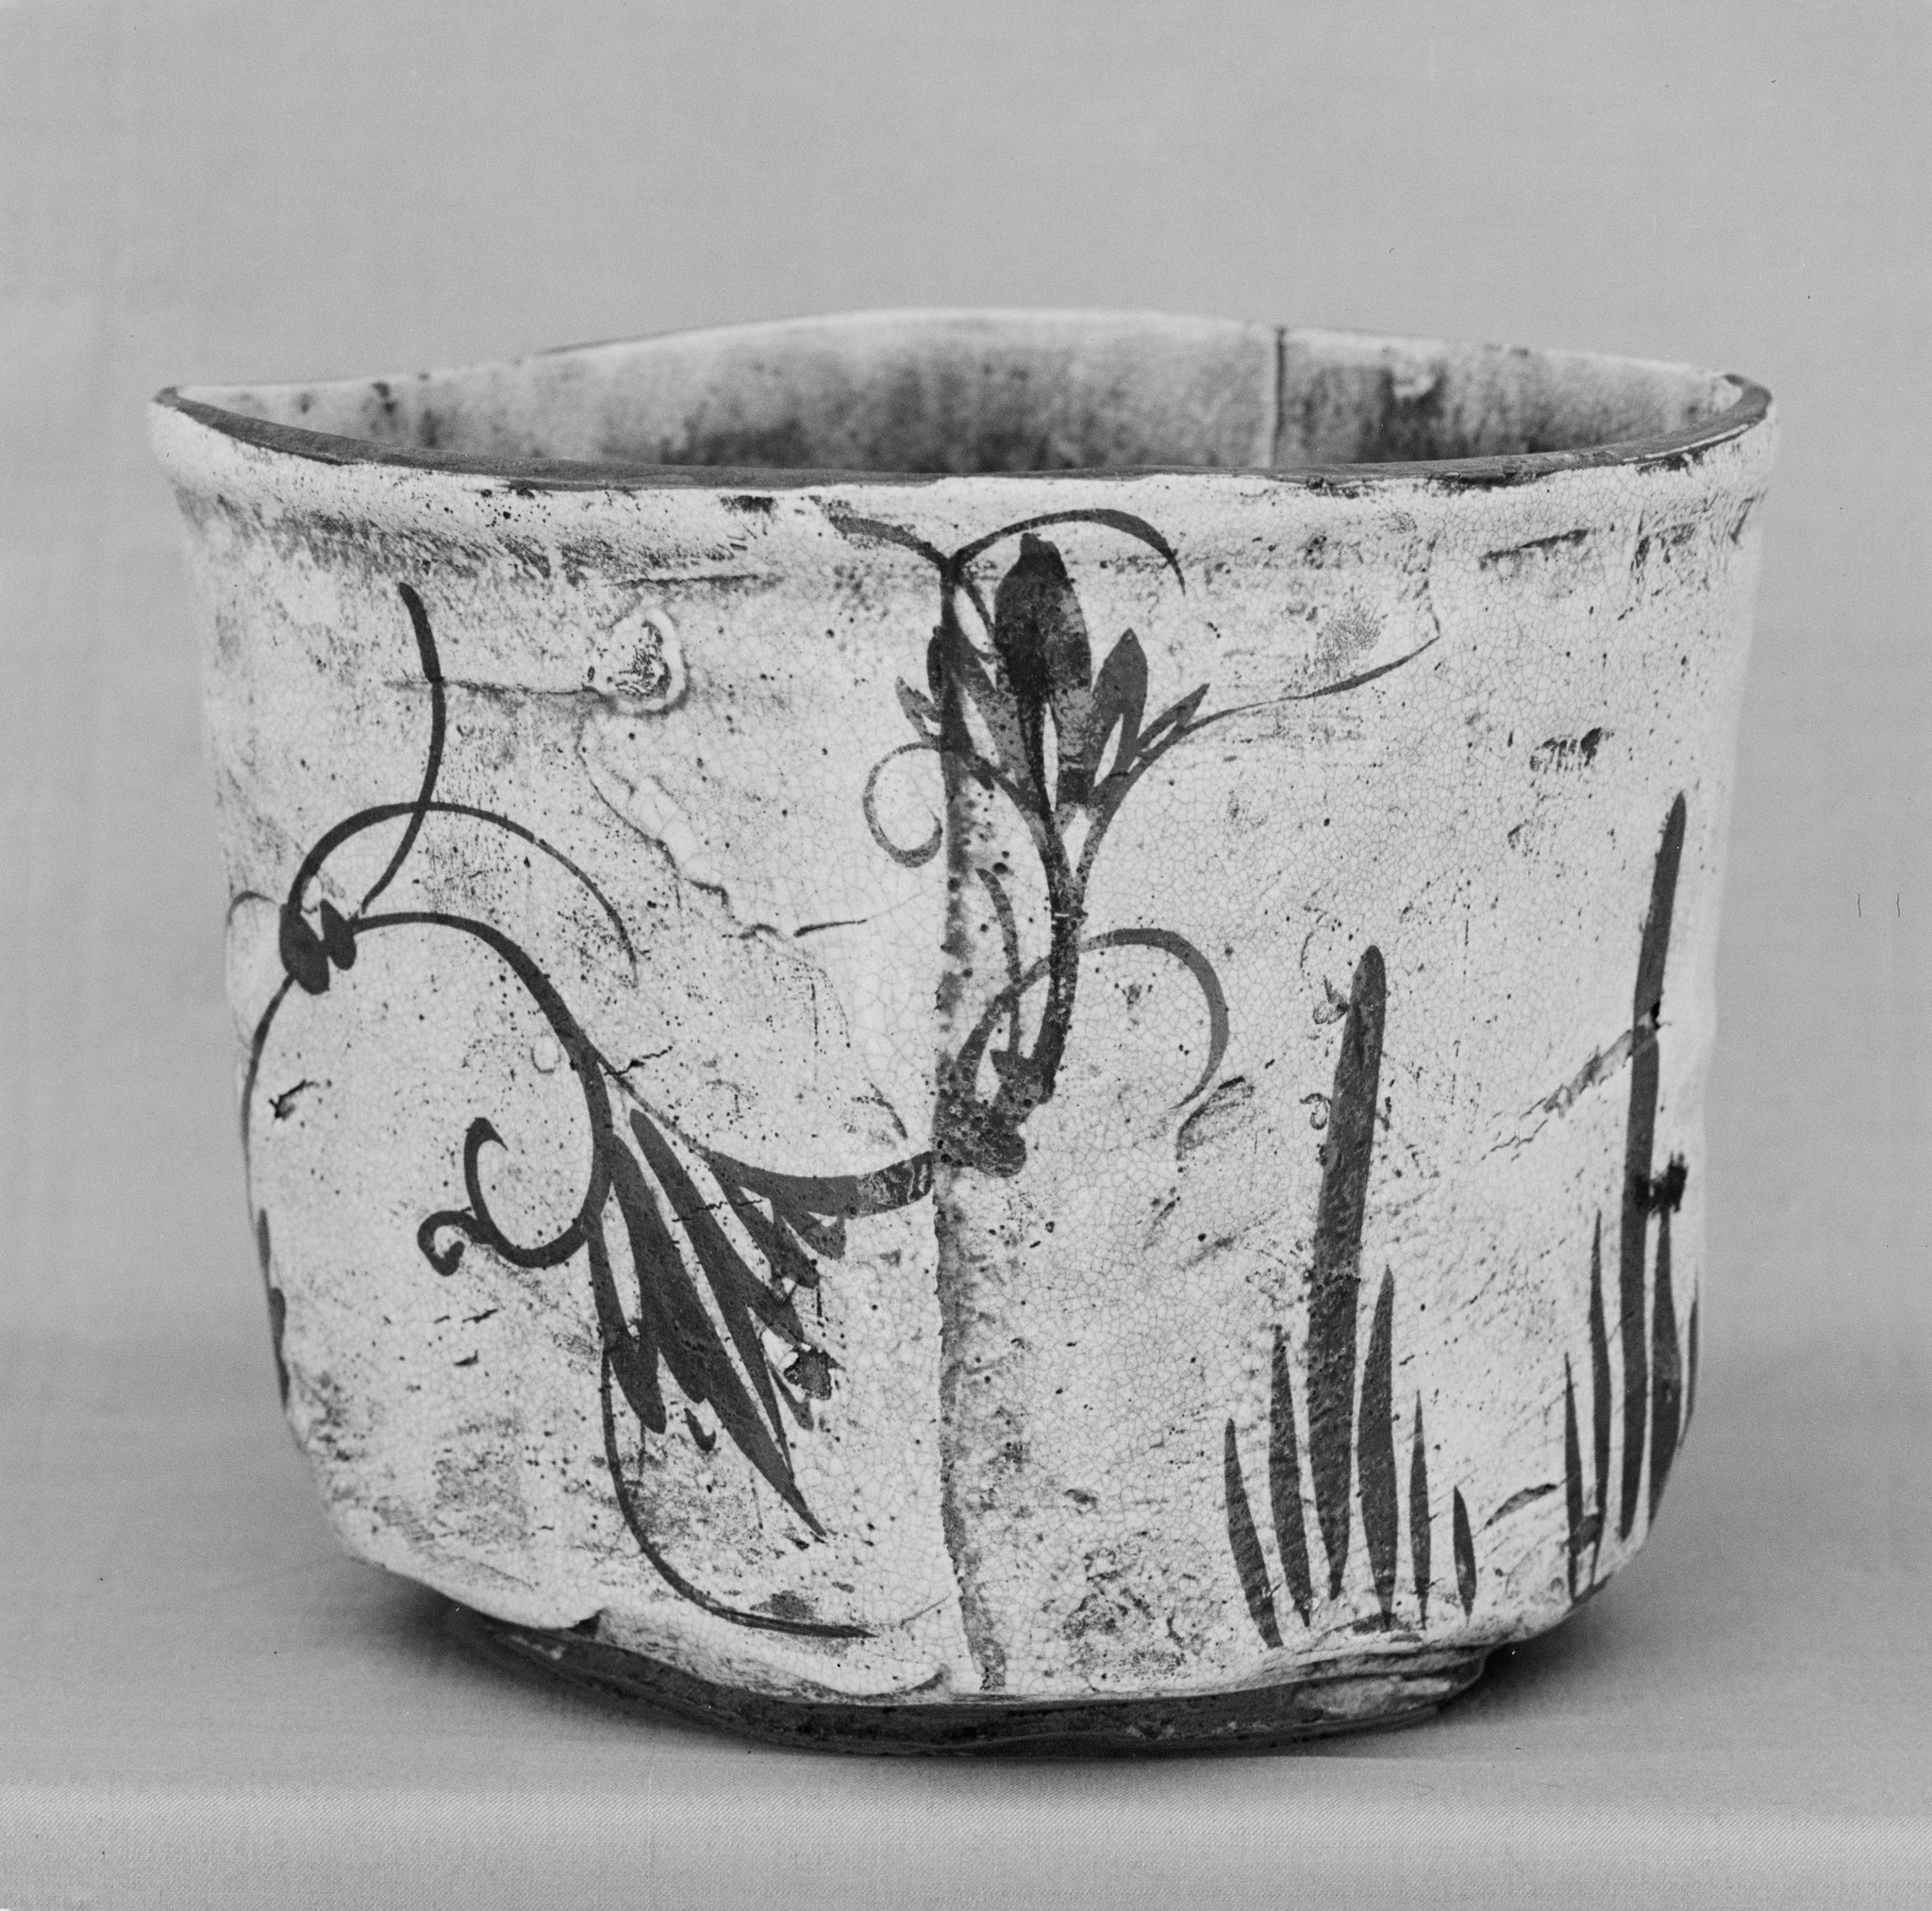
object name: bowl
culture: japanese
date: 1701-1800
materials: clay, glaze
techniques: overglaze